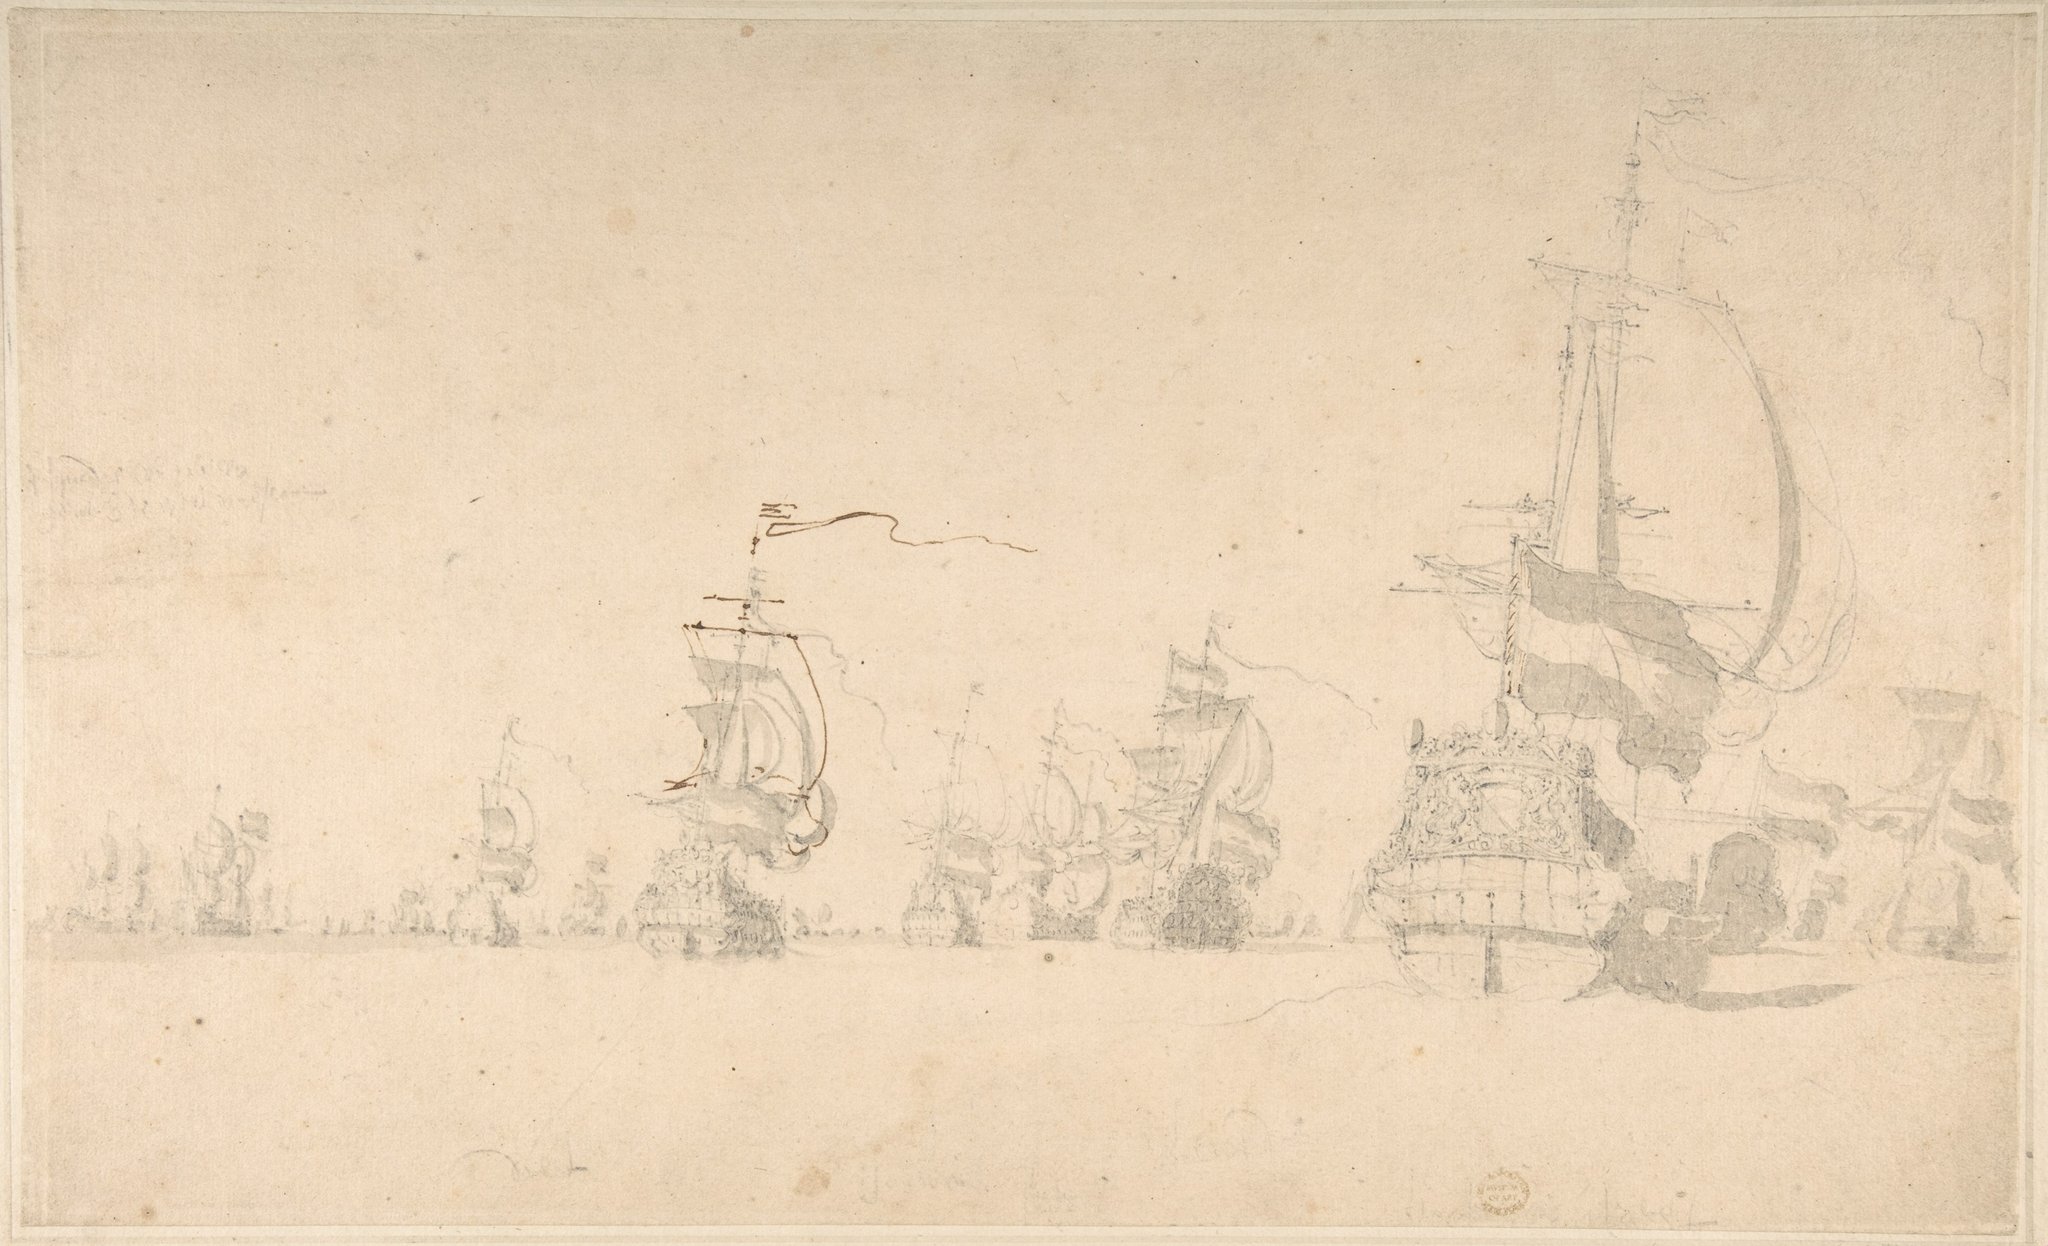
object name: drawing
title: A Fleet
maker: willem van de velde (ii)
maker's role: artist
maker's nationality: dutch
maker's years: 1633-1707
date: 1634-1733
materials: chalk, ink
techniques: pen, wash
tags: ships